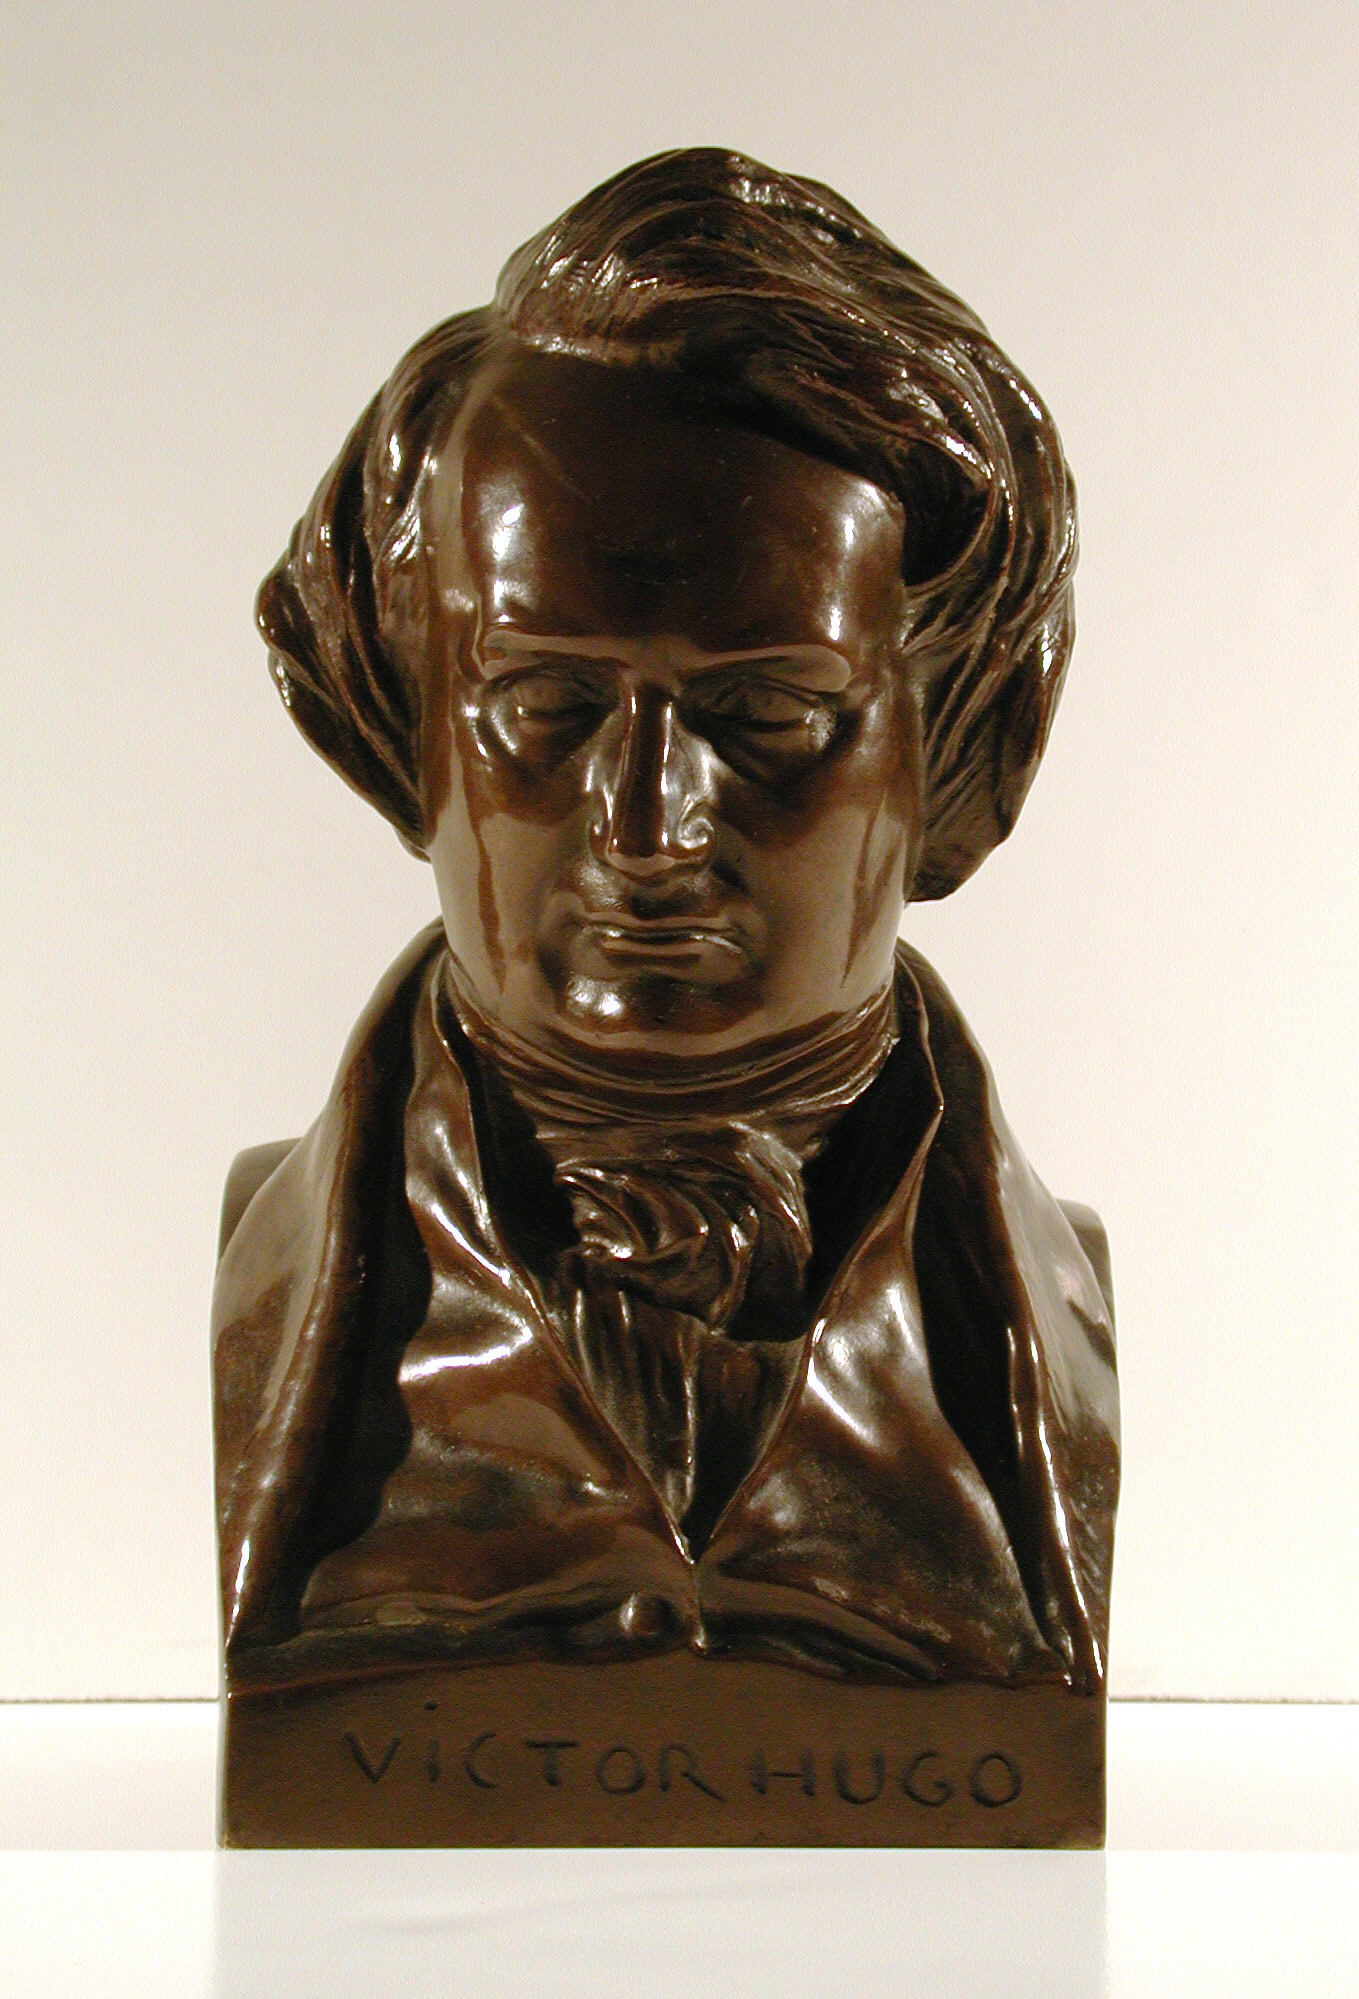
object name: bust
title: Victor Hugo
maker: pierre jean david d'angers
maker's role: artist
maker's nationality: french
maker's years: 1788-1856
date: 1867-1900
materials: bronze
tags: men,portraits